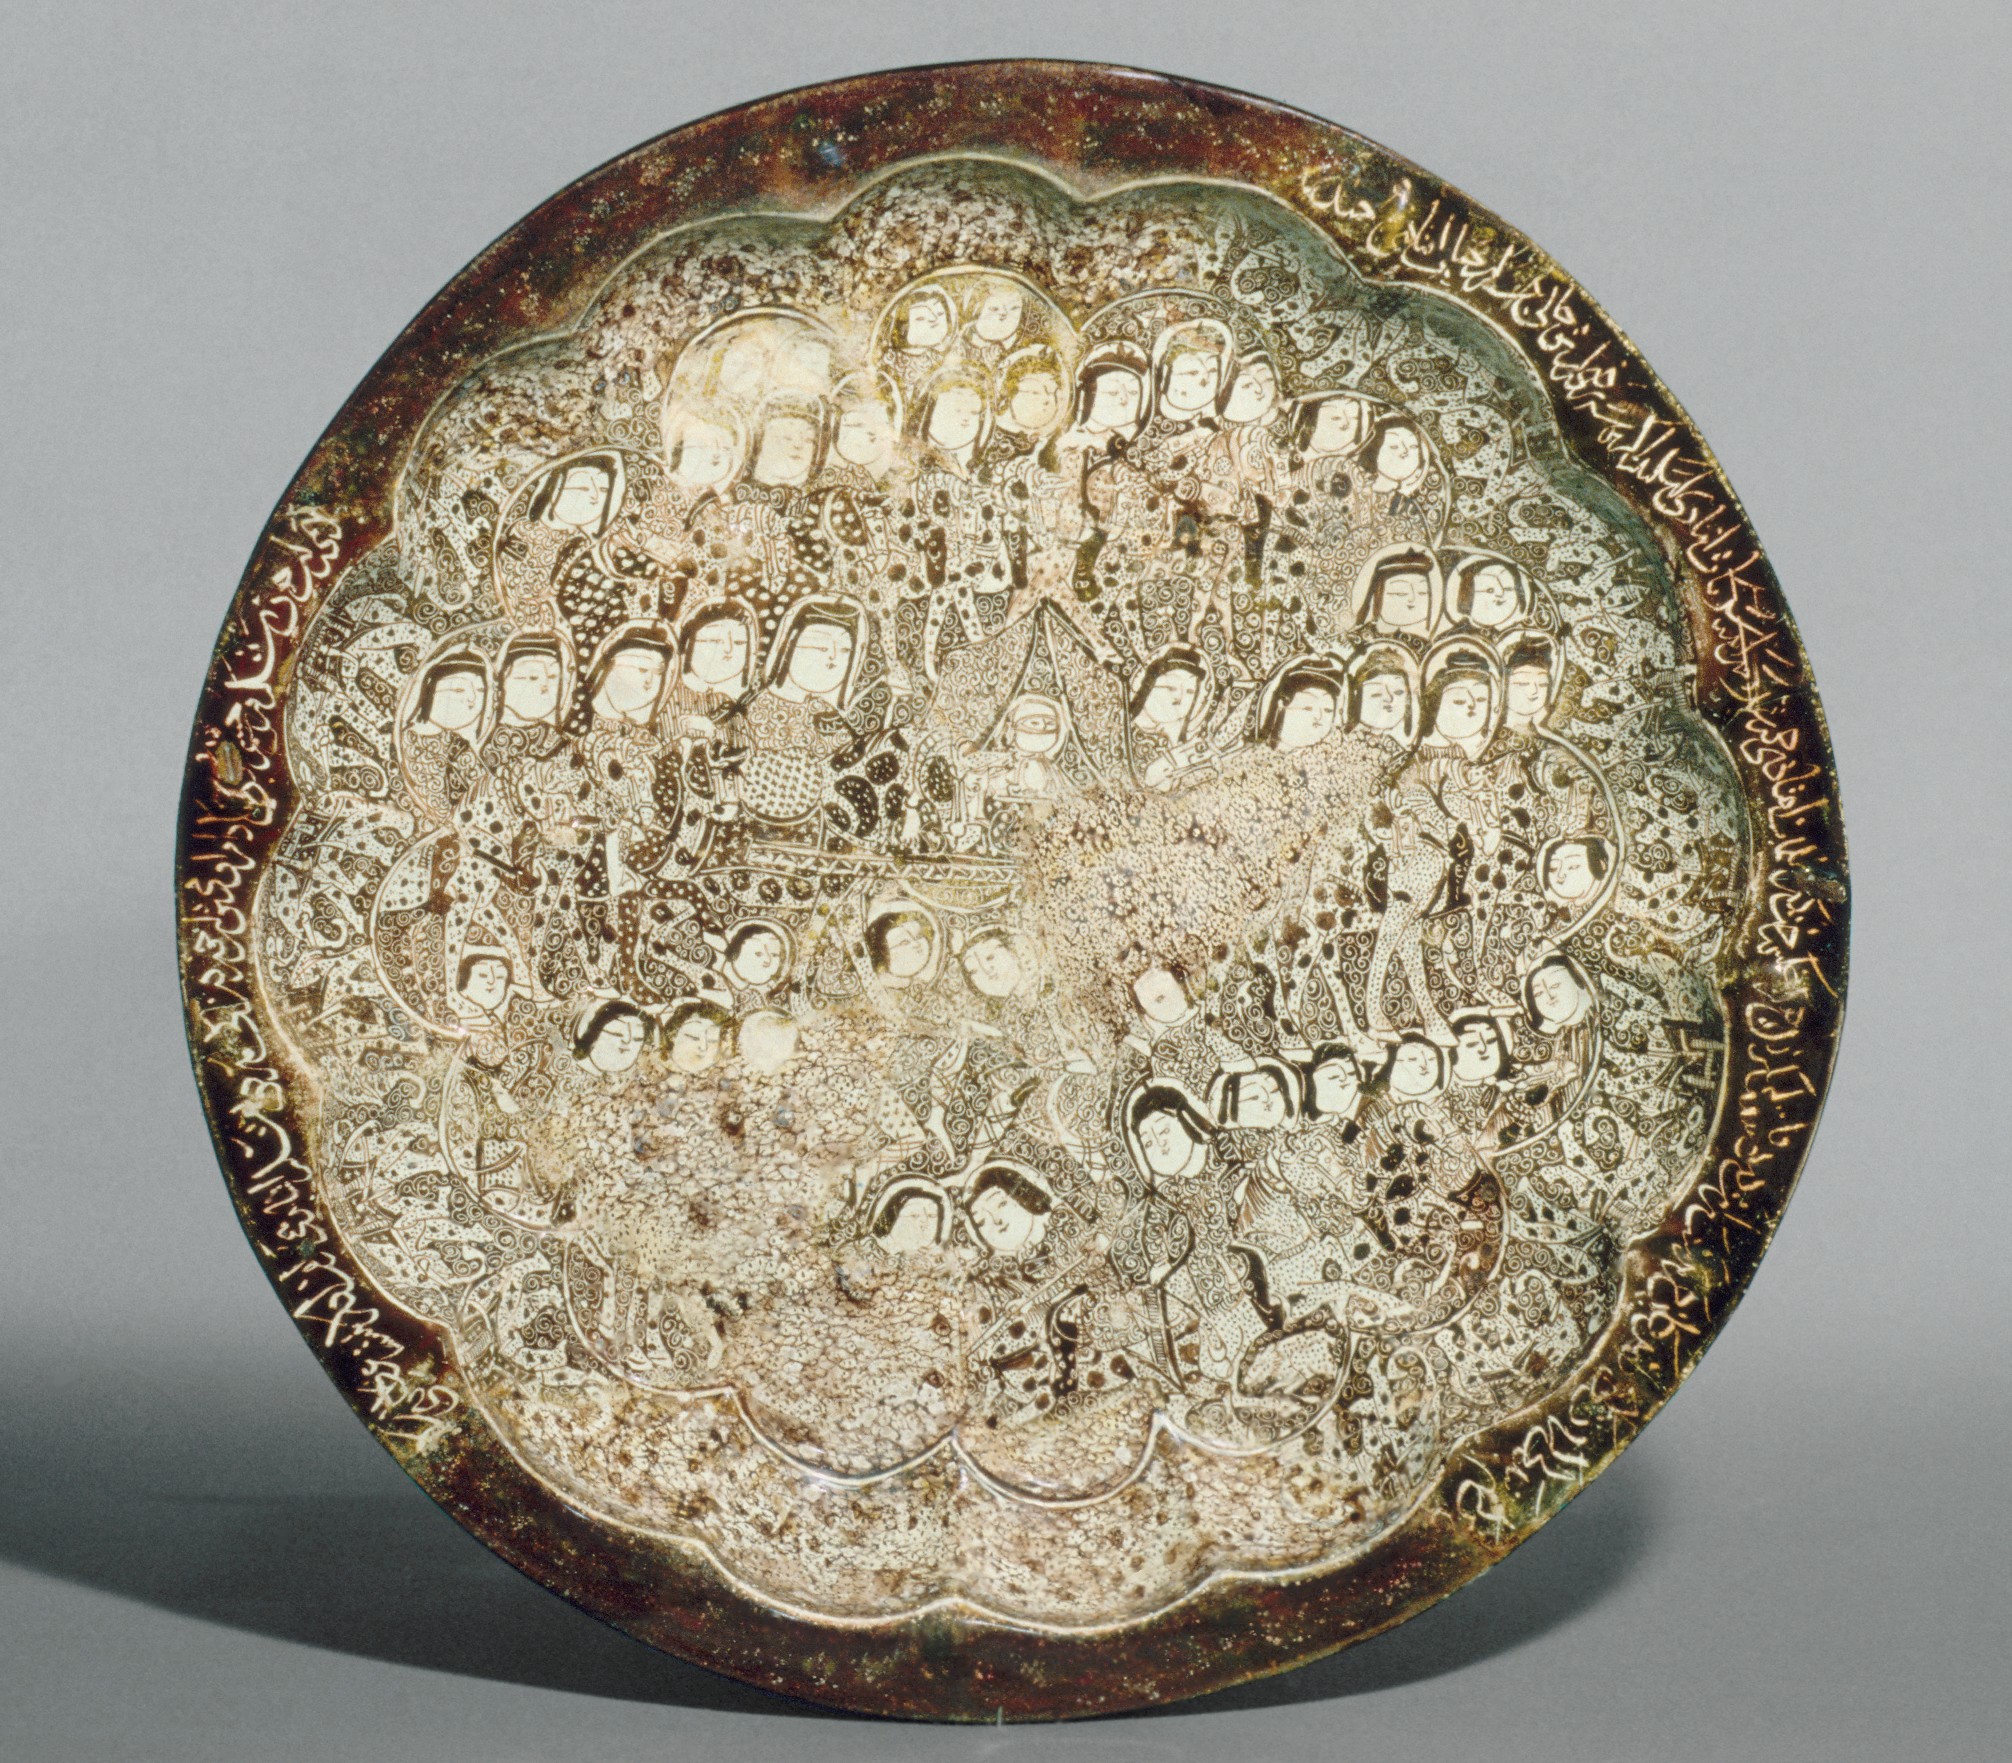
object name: dish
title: Dish depicting a Wedding Procession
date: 1201-1225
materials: glaze, stonepaste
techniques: luster painting, molding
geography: iran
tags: men,women,weddings,processions